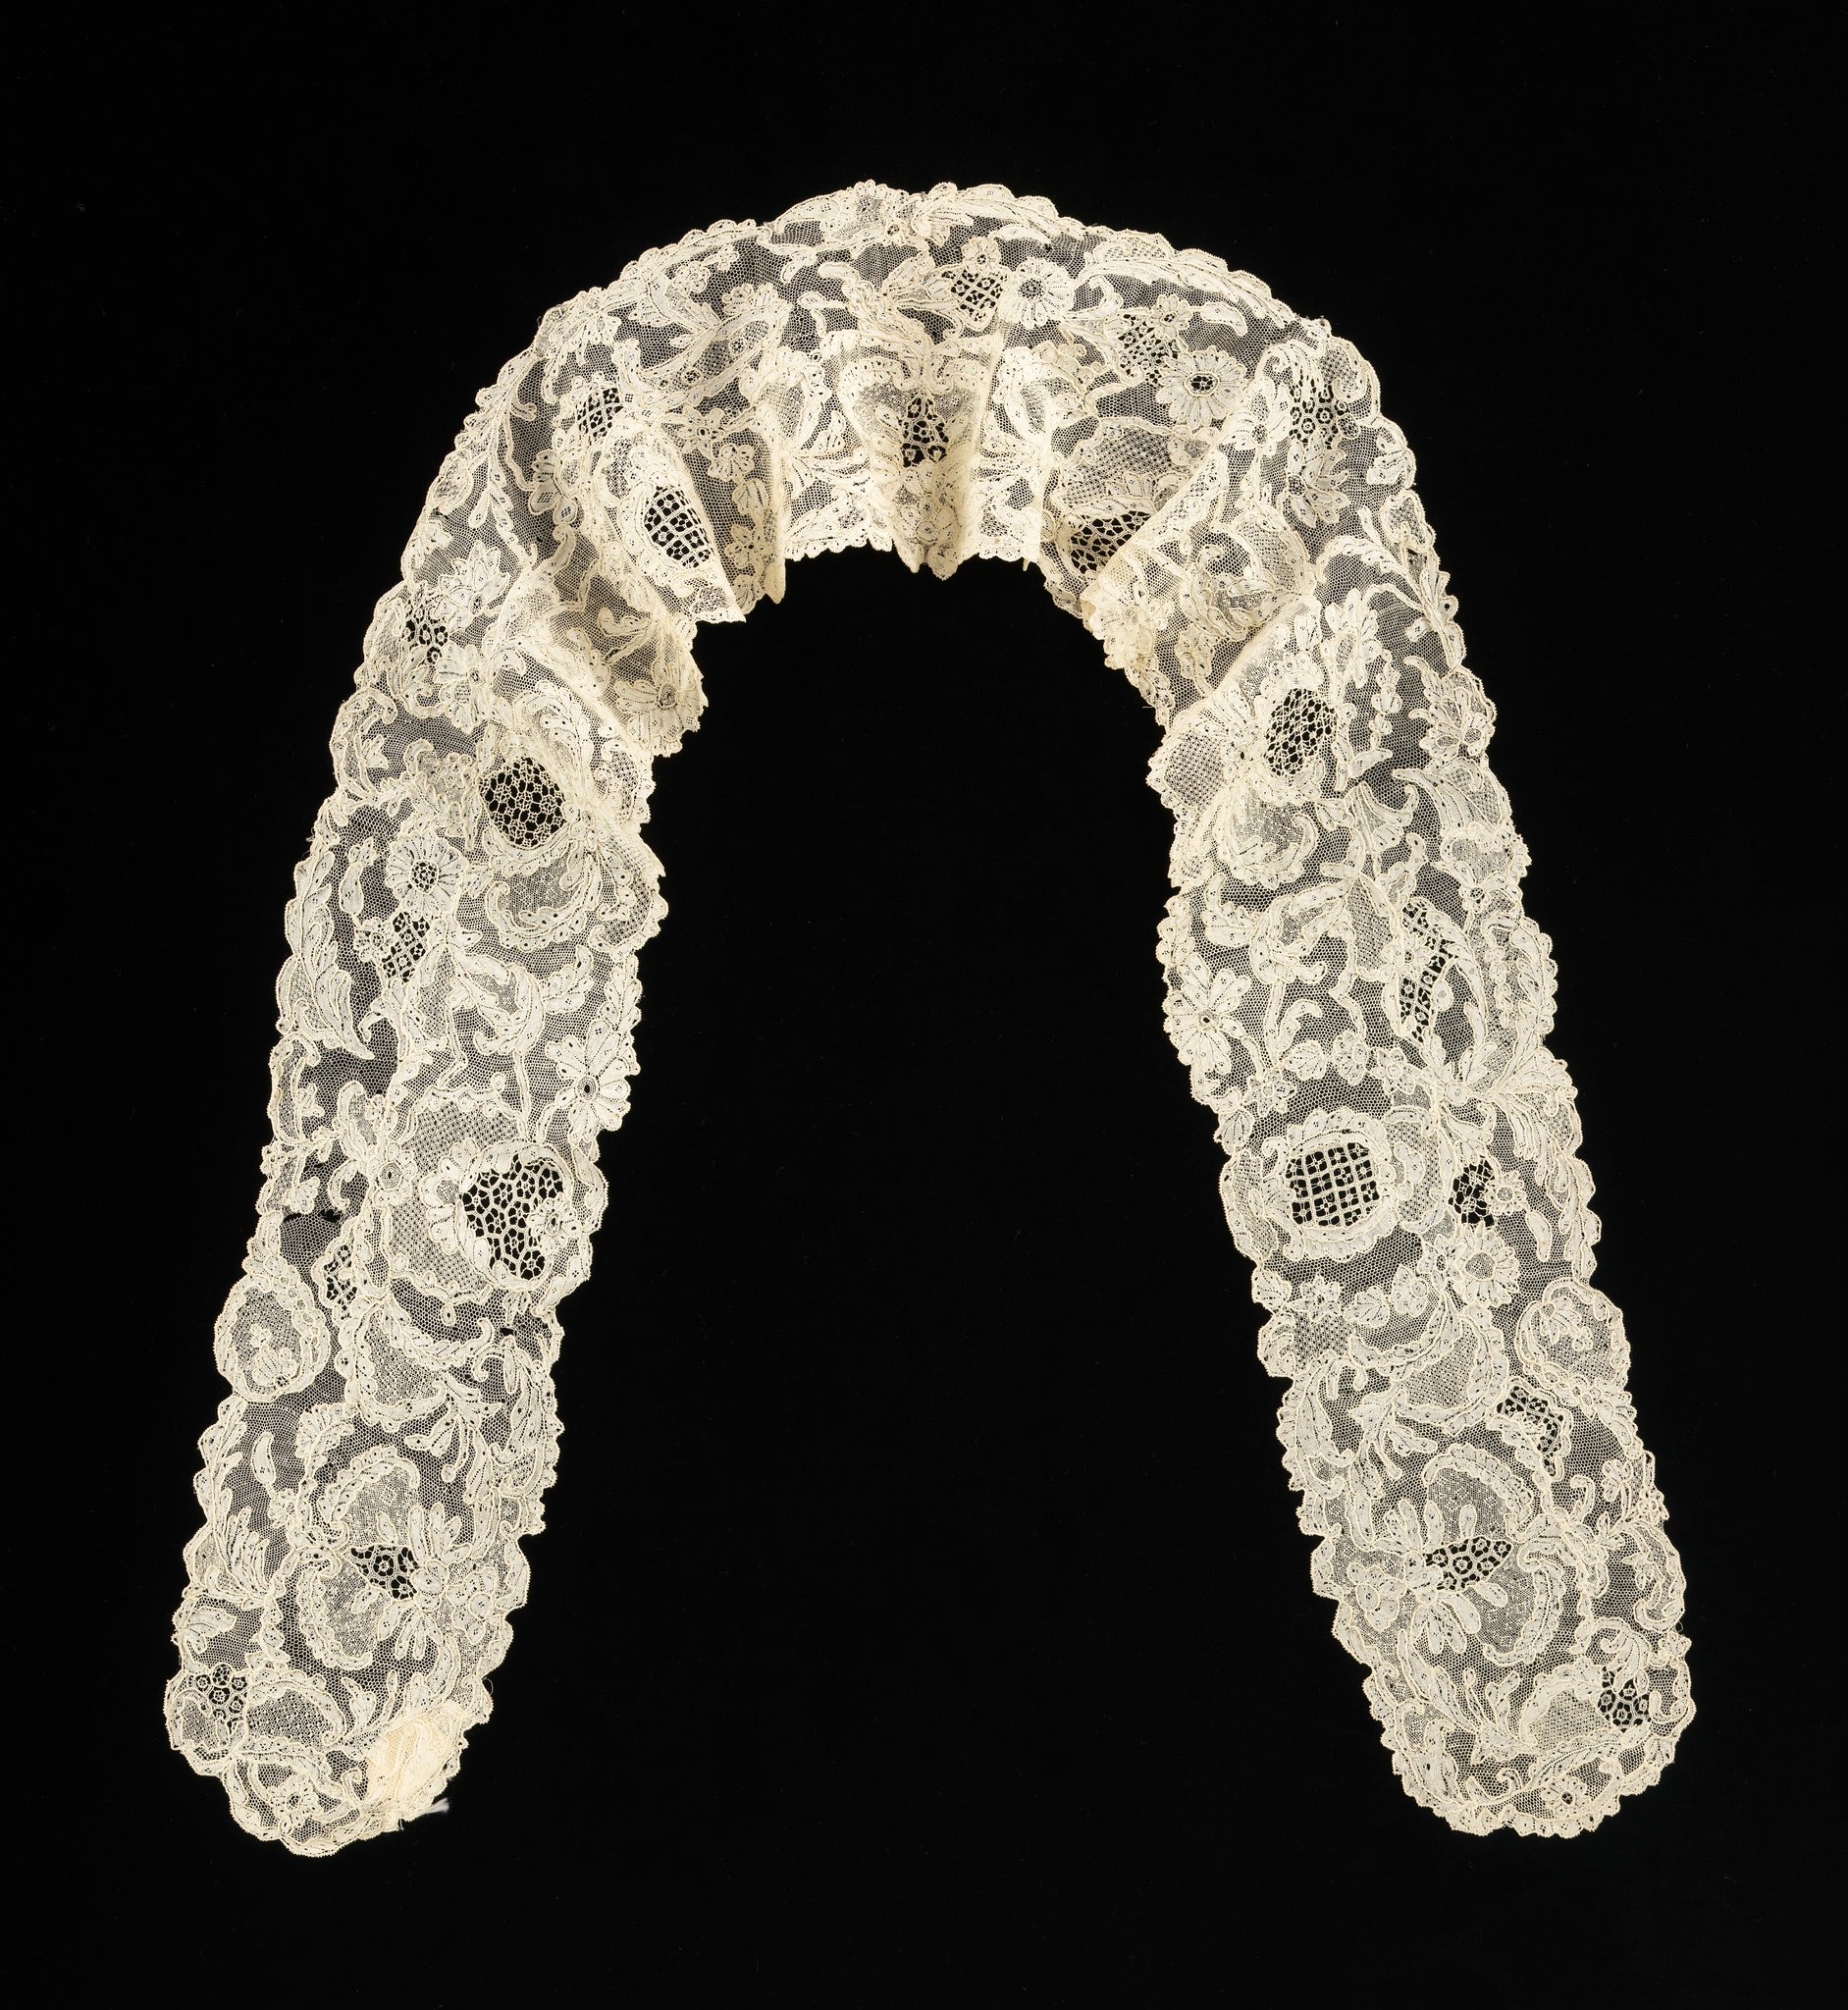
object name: lappet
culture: french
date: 1740-1760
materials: linen